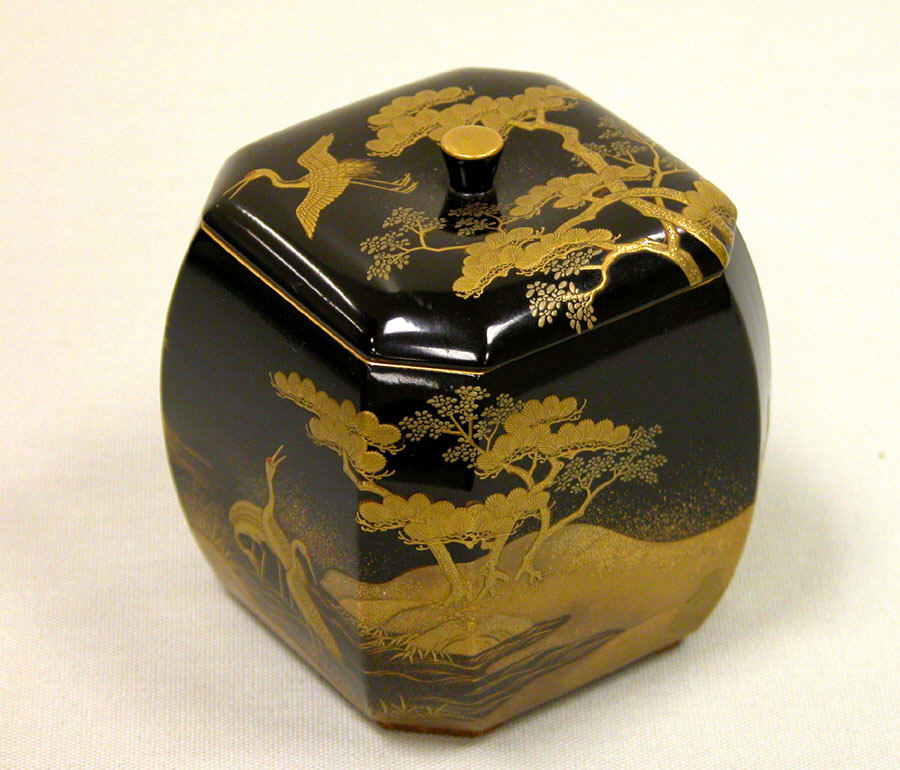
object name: tea jar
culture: japanese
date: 1701-1800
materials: gold, lacquer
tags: cranes,trees